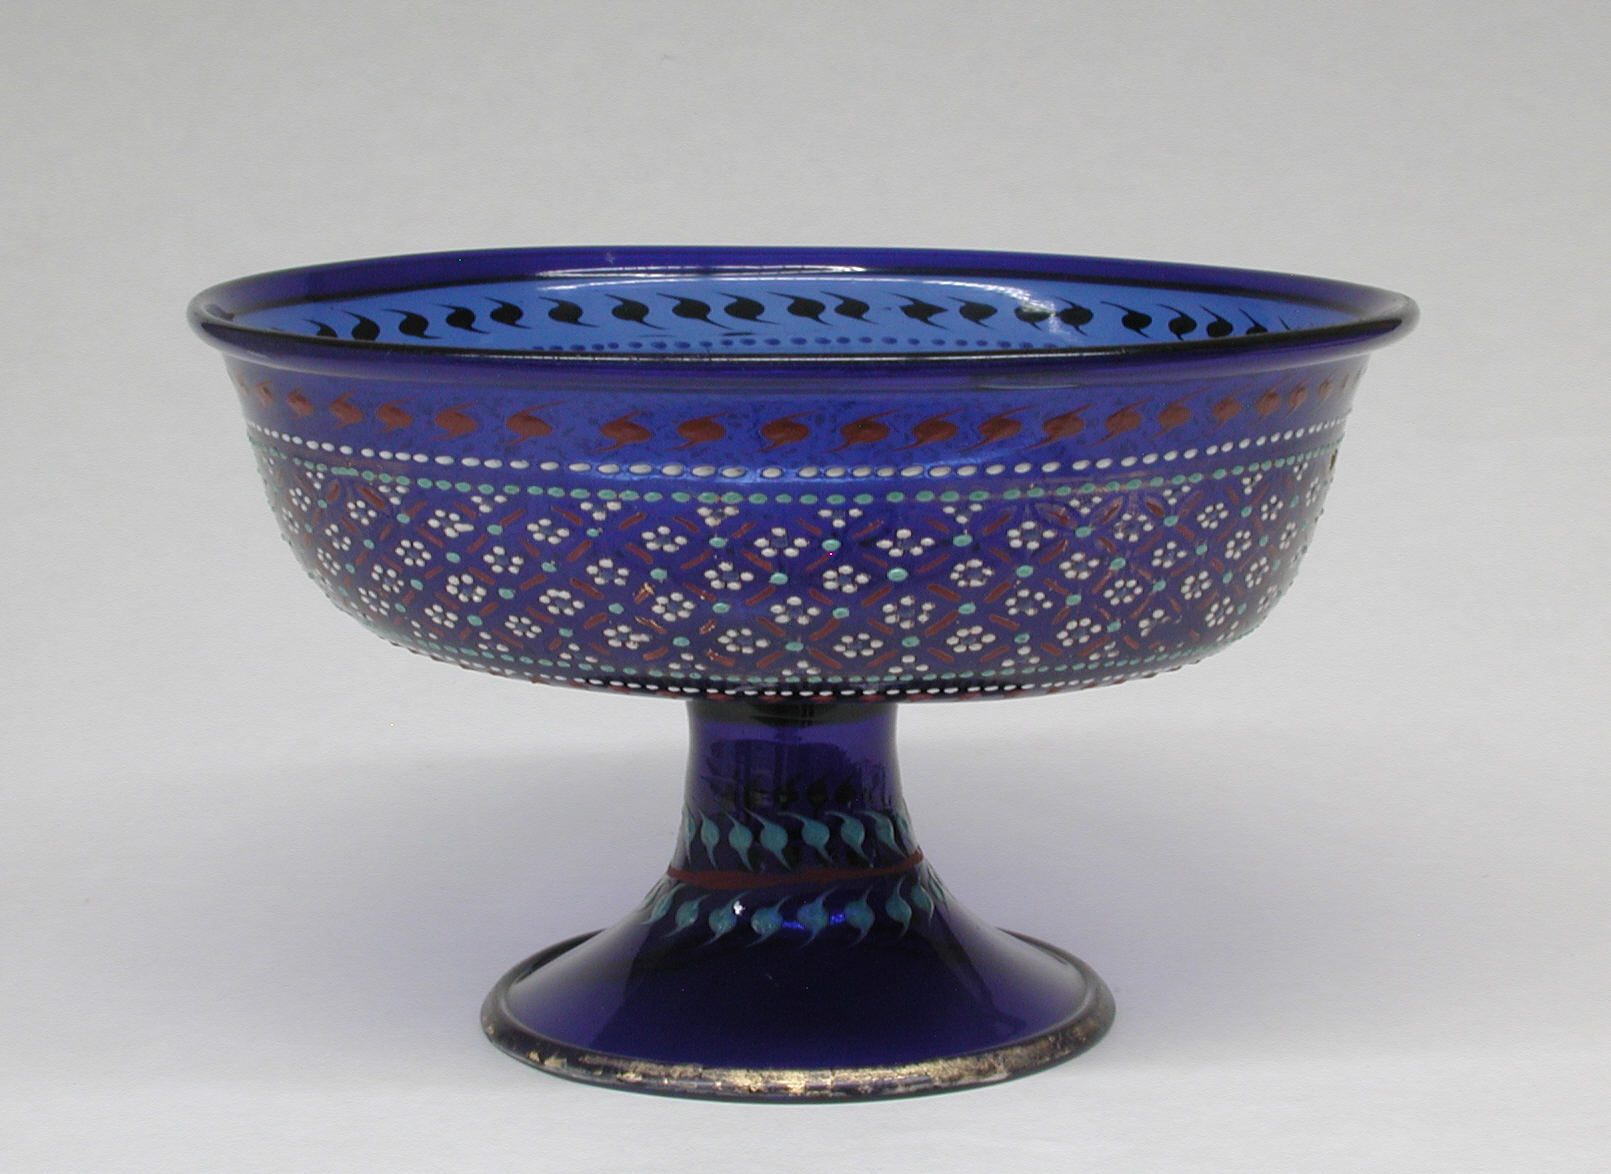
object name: bowl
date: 1467-1500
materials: gilt, glass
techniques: enamel